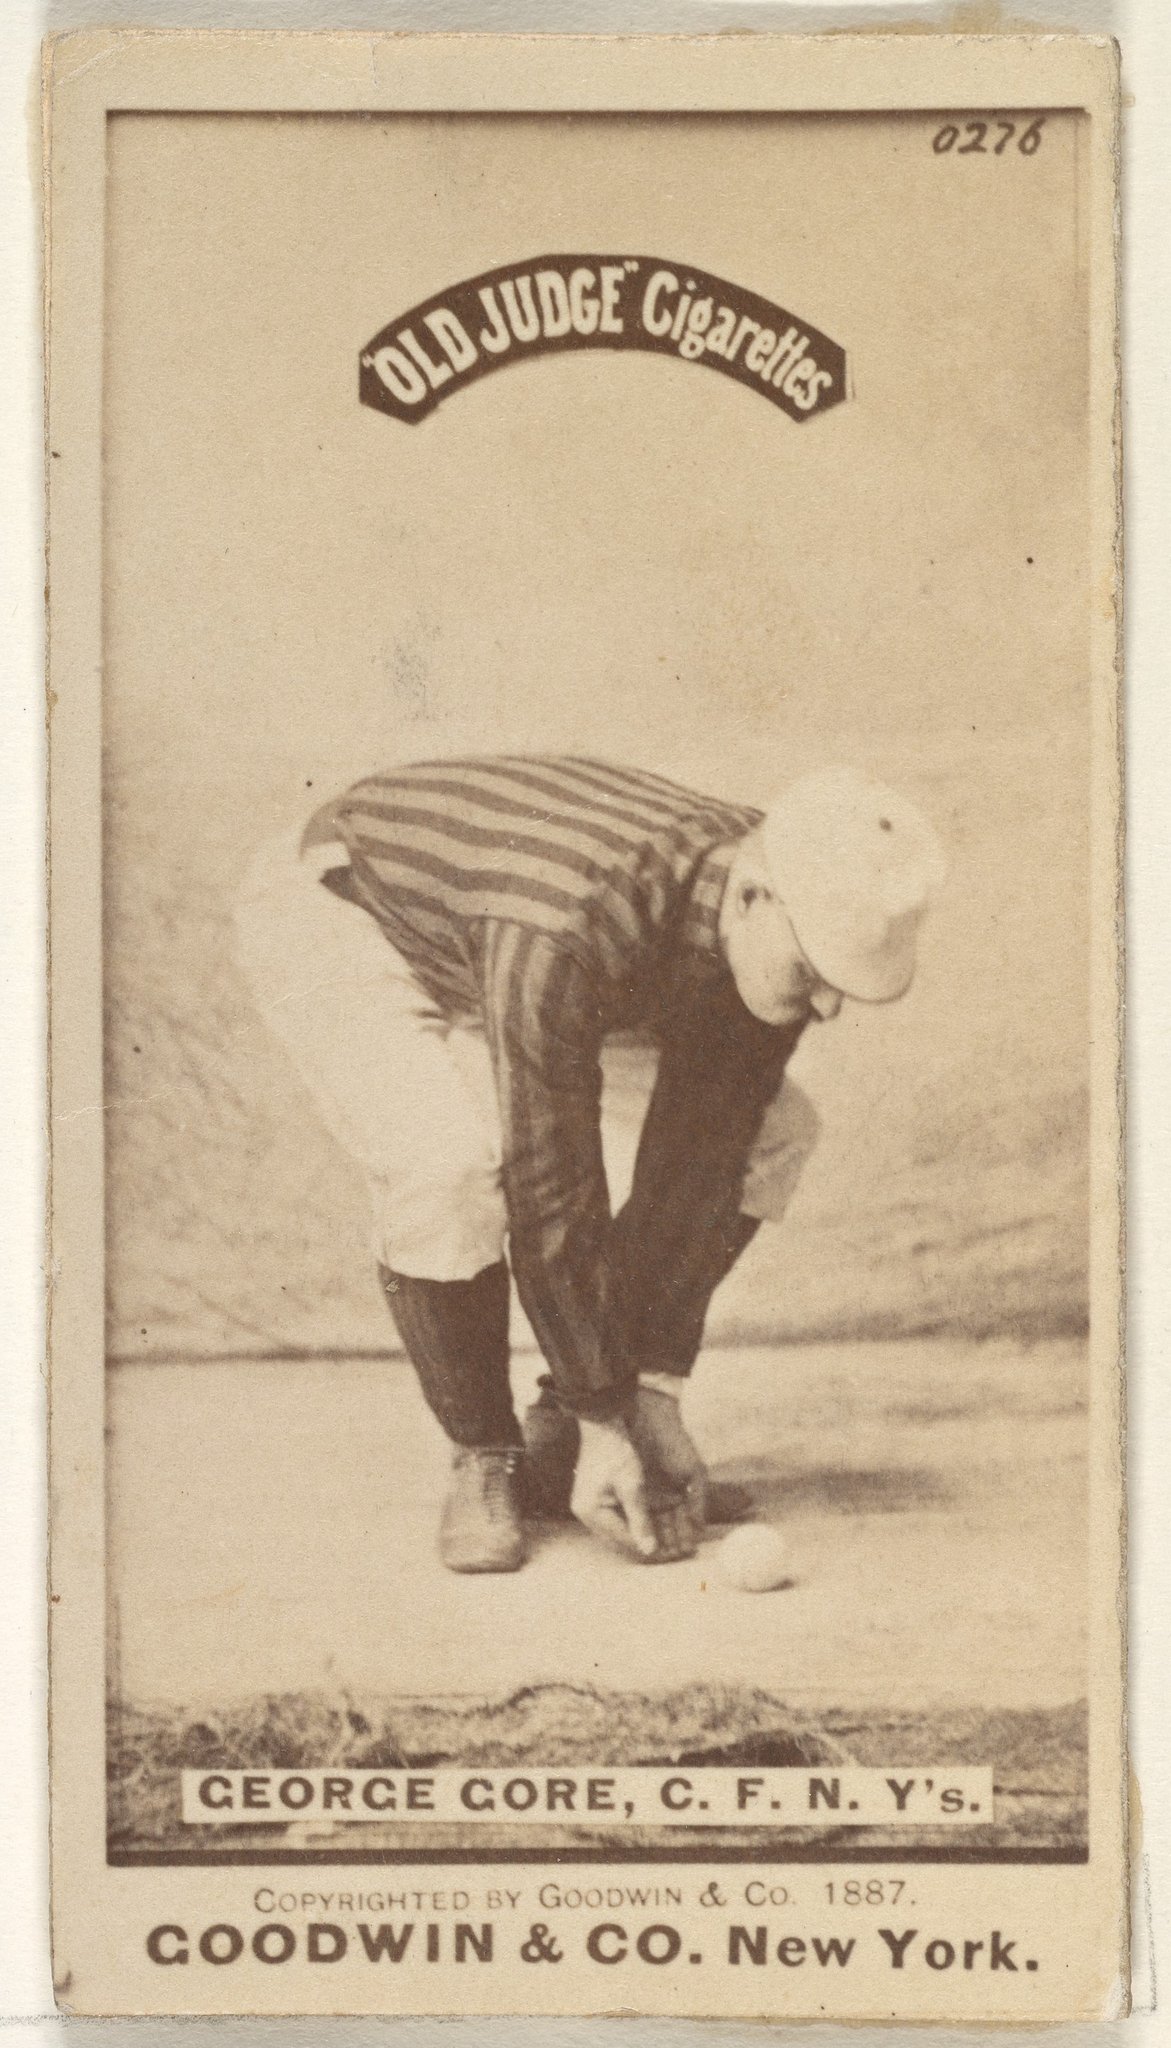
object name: baseball card, photograph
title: George F. "Piano Legs" Gore, Center Field, New York, from the Old Judge series (N172) for Old Judge Cigarettes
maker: goodwin & company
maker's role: publisher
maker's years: 1850-1950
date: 1887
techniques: albumen silver print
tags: men,portraits,baseball,athletes